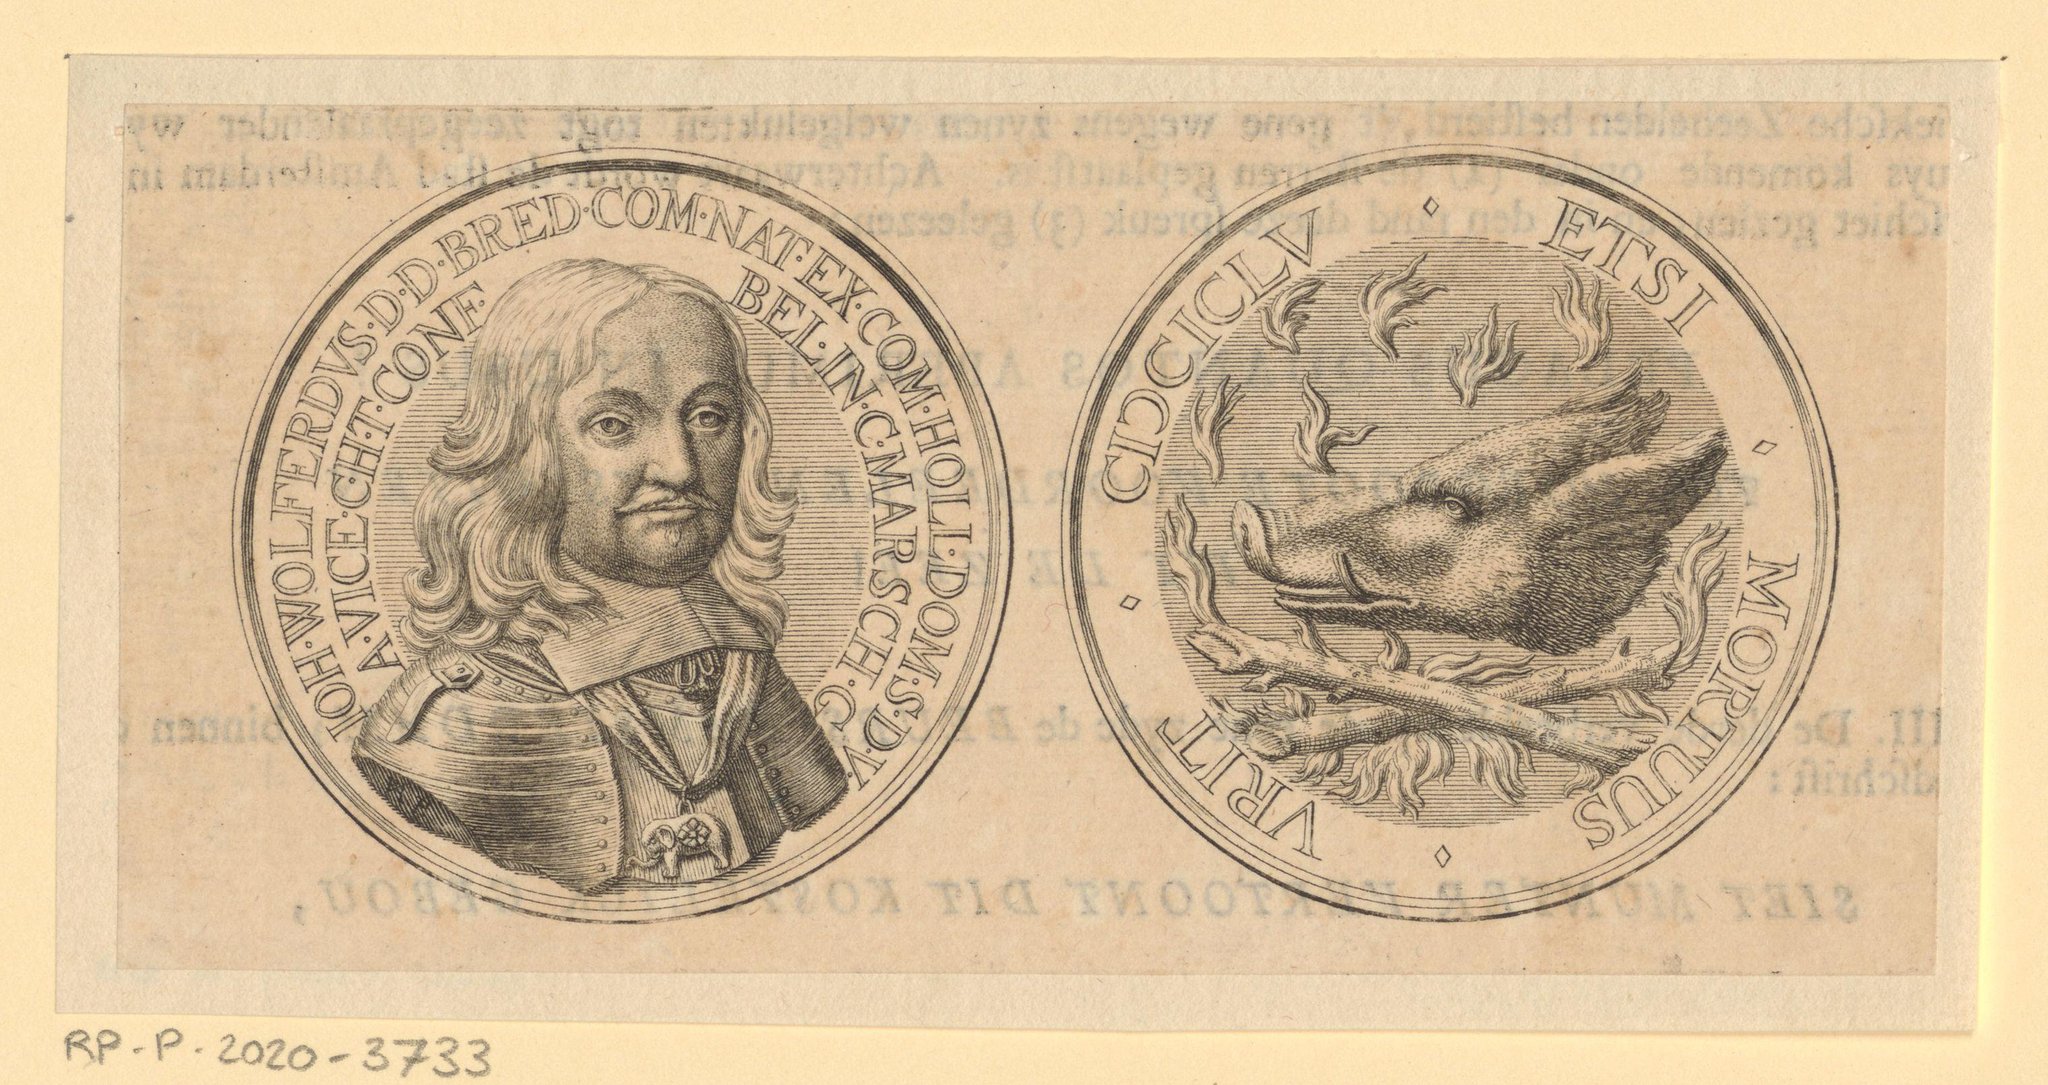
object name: print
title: Penning met portret van Joan Wolfert van Brederode en een everzwijn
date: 1726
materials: paper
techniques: engraving, etching, letterpress printing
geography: the hague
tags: historical persons, hoofed animals: boar, medal (considered as a piece of sculpture, regardless of its specific function)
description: Prent uit: Loon, Gerard van. Beschryving der Nederlandsche historiepenningen (...). Den Haag: Christiaan van Lom, Isaac Vaillant, Pierre Gosse, Rutgert Christoffel Alberts en Pieter de Hondt, 1726, dl. 2, p. 402.